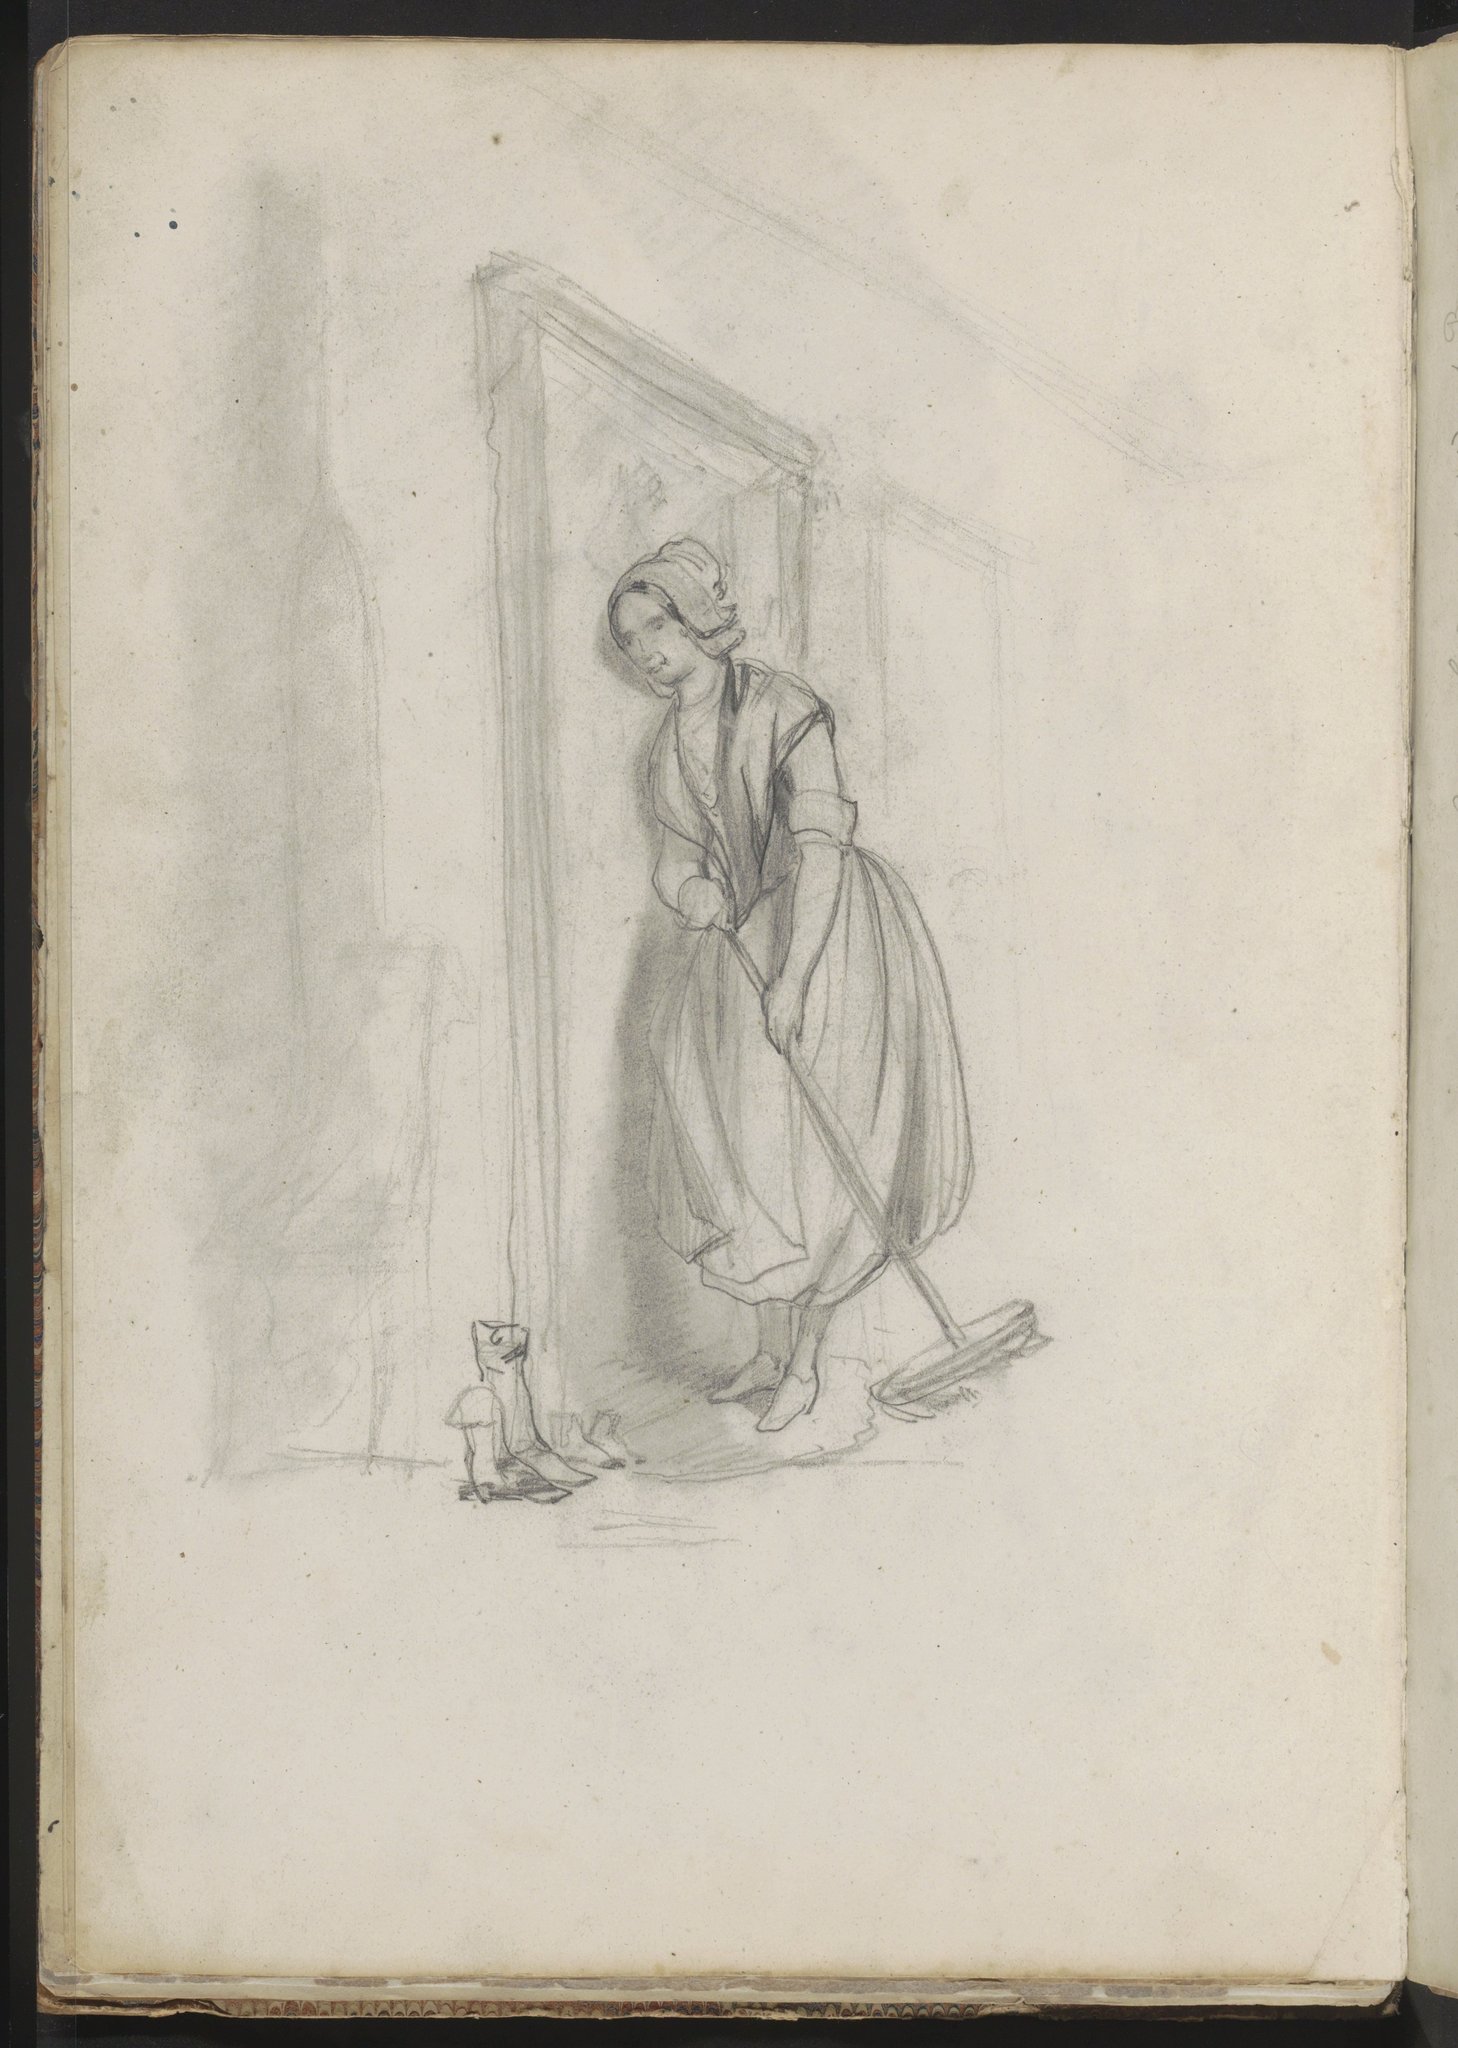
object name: sketchbook leaf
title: Vrouw met een bezem in een deuropening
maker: johannes huybertus van hove bzn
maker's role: print maker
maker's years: 1827-1881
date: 1837-1881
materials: paper, pencil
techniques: stumping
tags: open door, sweeping (~ cleaning the house)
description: Naast de deuropening staat een paar schoenen. Blad 28 verso uit een schetsboek met 33 bladen en 10 losse tekeningen.